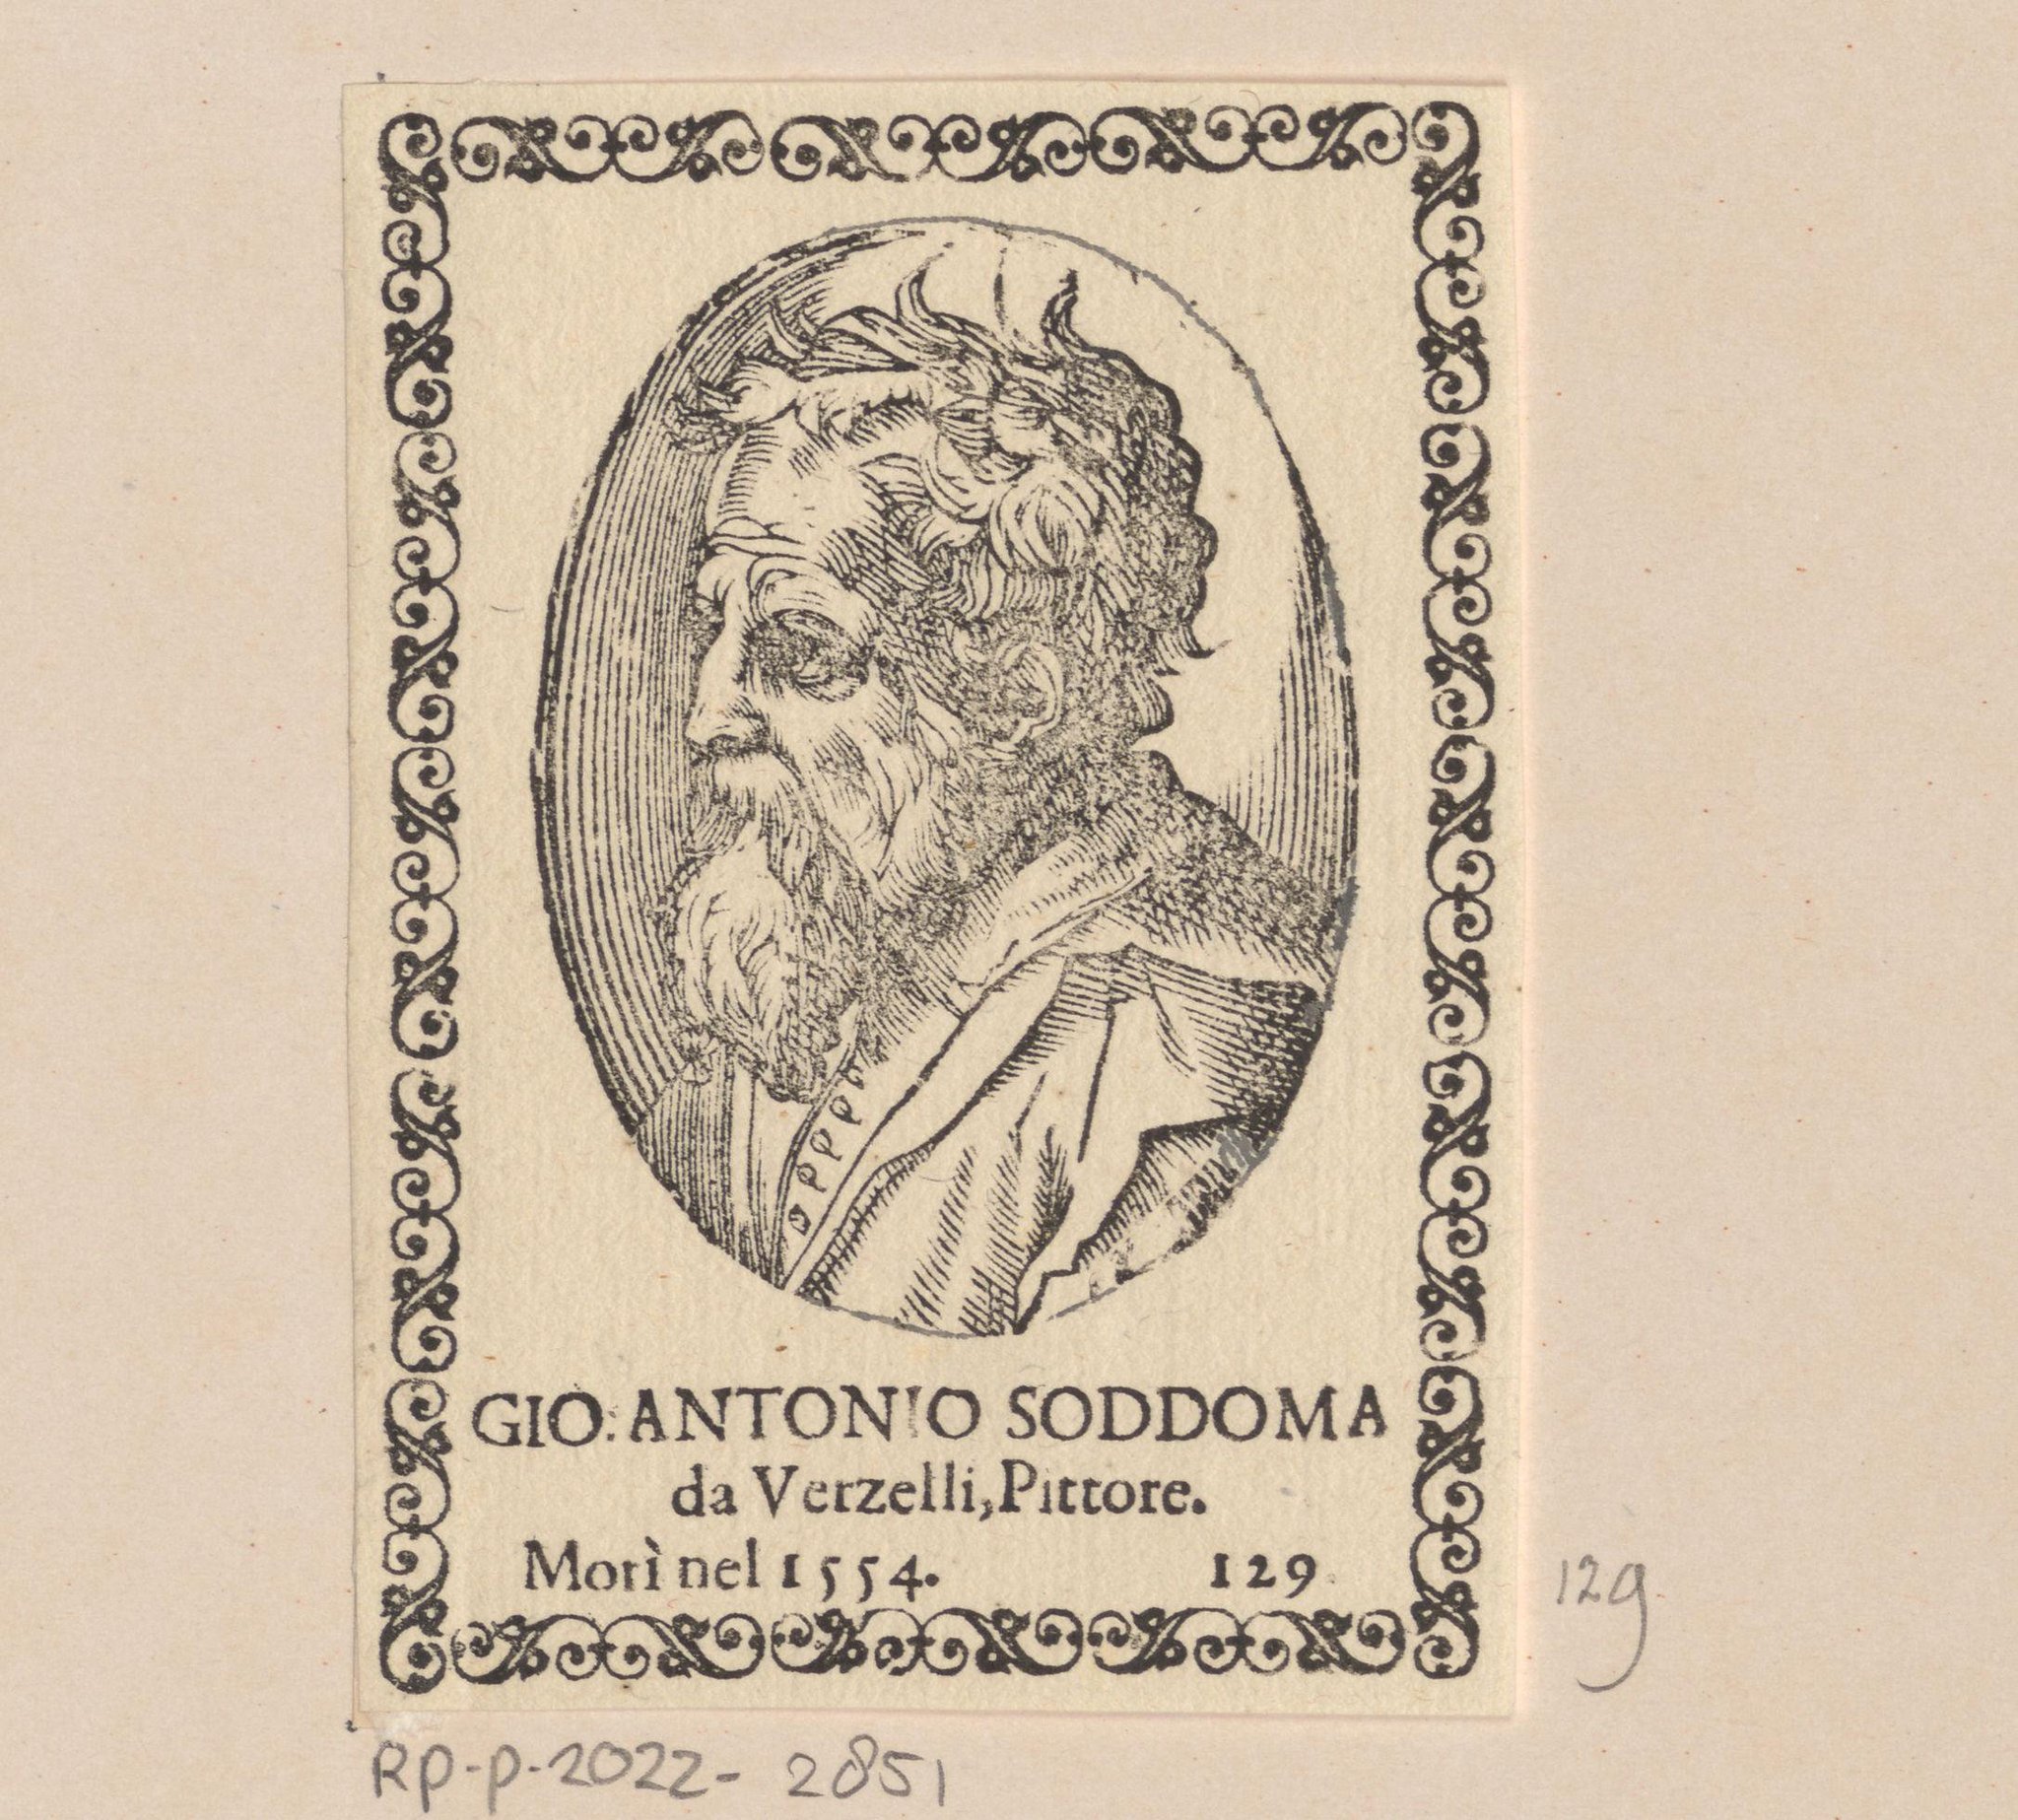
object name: print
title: Portret van Il Sodoma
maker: cristoforo coriolano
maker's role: print maker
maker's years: 1540-1610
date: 1568-1650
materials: paper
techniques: letterpress printing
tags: painter, il sodoma, historical persons, portrait, self-portrait of artist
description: Prent komt uit een editie van Vasari's 'Vite'. Prent met een andere omlijsting is gebruikt in de editie uit 1568: Vasari, Giorgio. Le vite de' piu eccellenti pittori scultori, e architettori. Florence: Filippo Giunta, 1568. En mogelijk in de editie uit 1647.